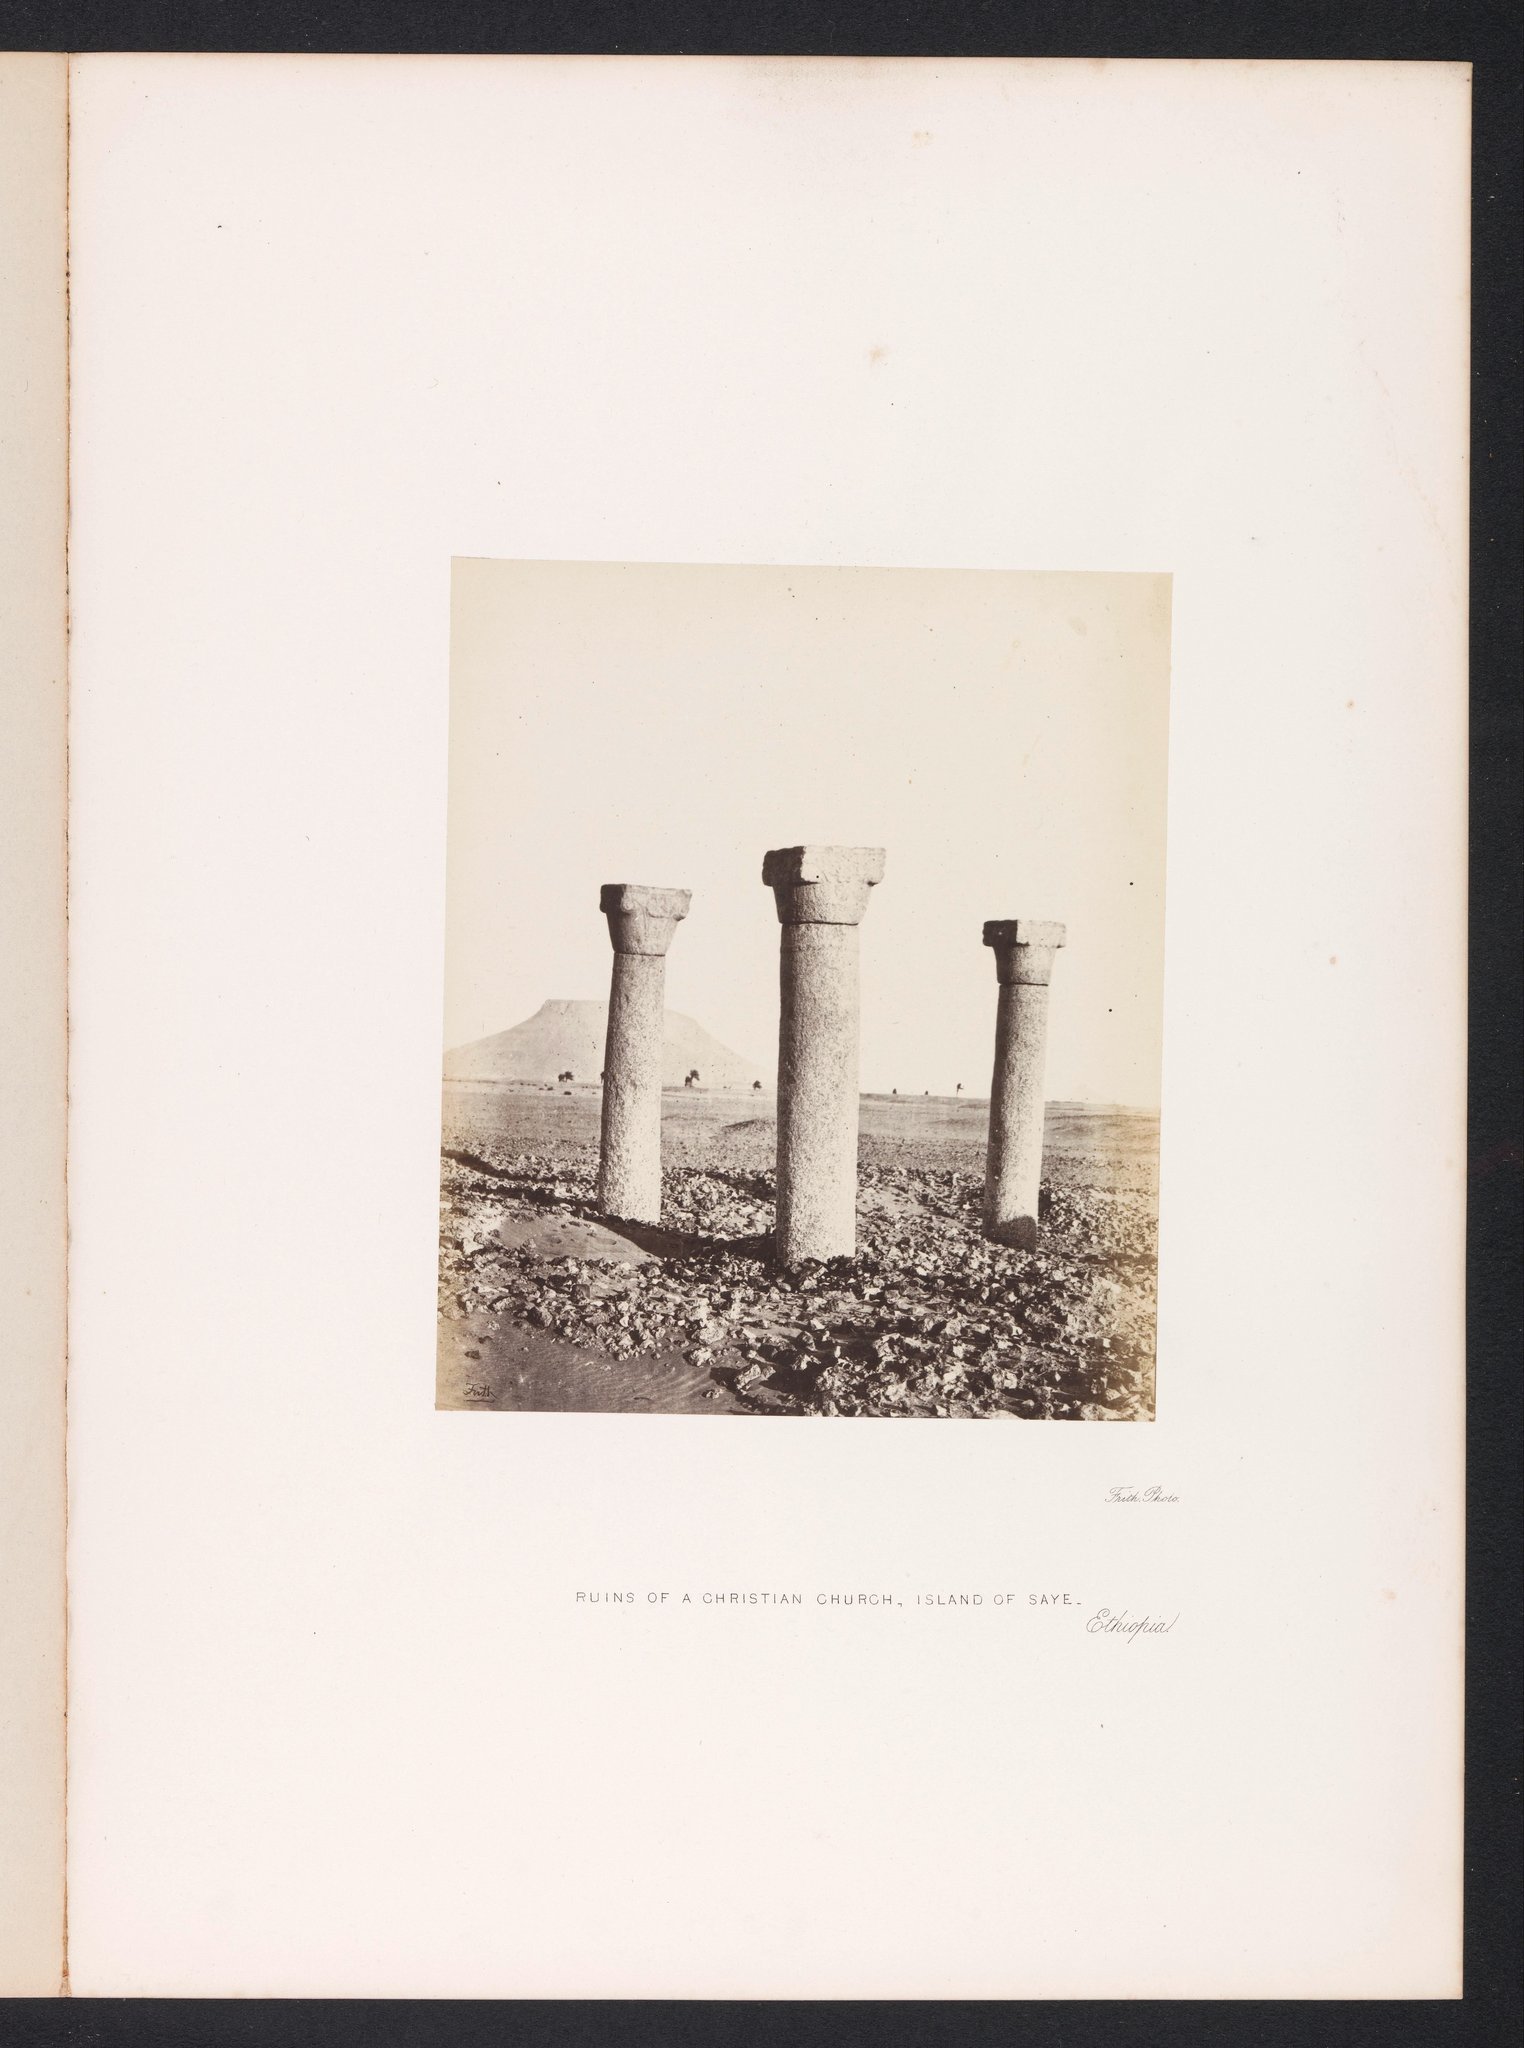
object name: photograph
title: Ruins of a christian church, island of Saye - Ethiopia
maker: francis frith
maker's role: publisher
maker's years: 1822-1898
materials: paper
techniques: albumen print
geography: ethiopia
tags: column, pillar ~ architecture, ruin of church, monastery, etc.